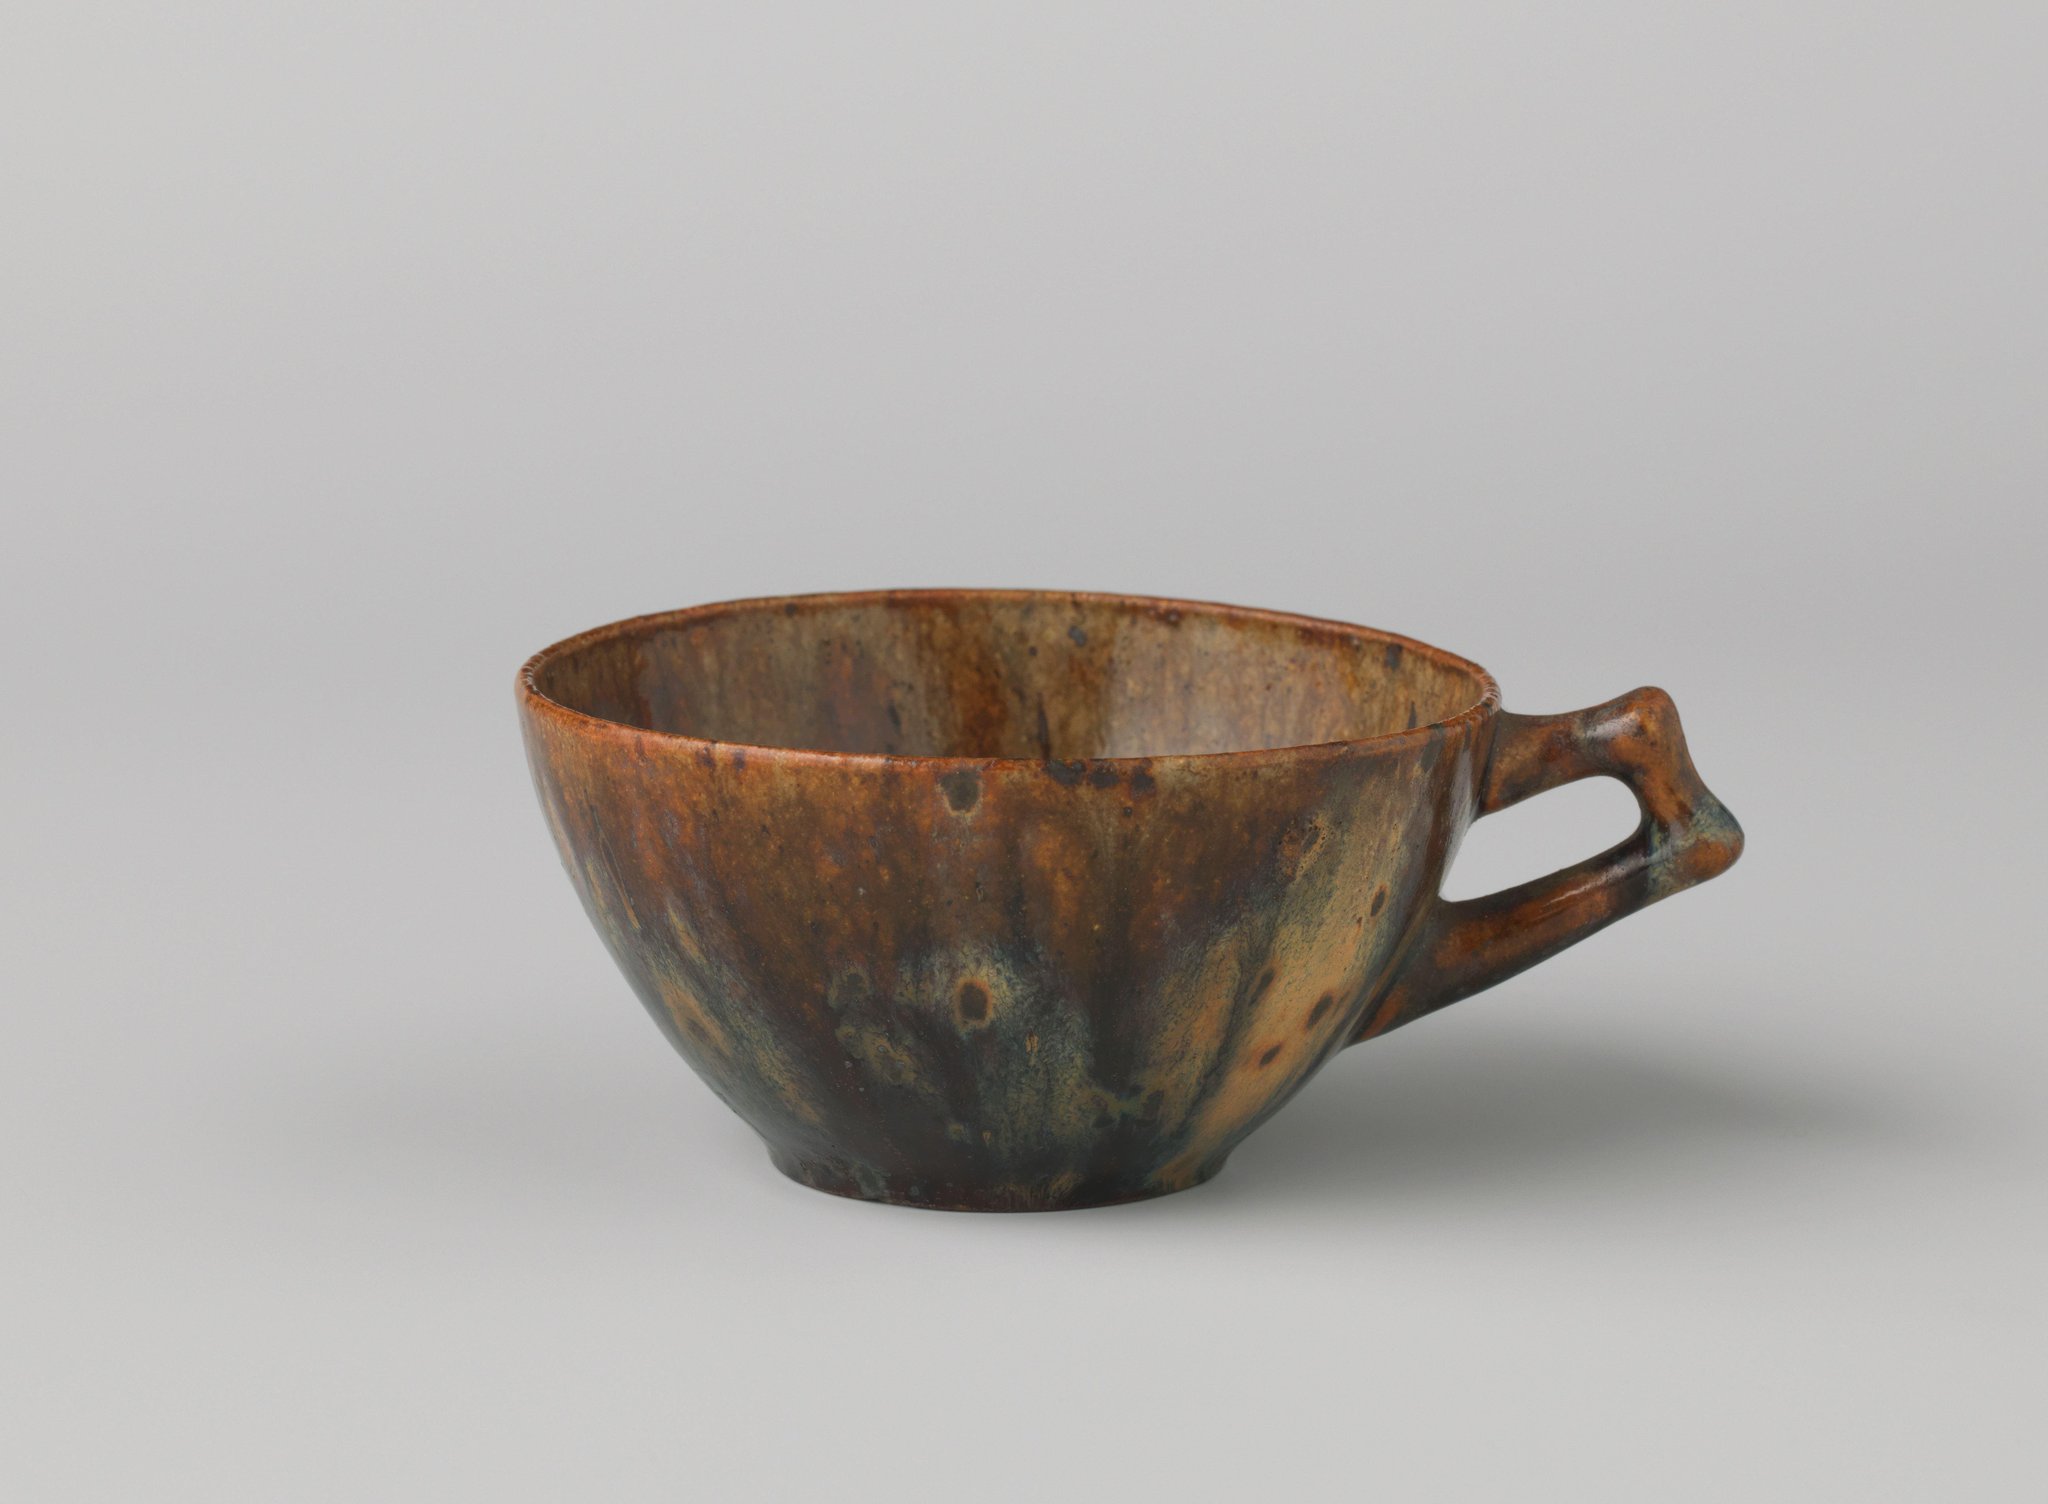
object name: cup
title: Set of Two Cups and Saucers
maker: pierre adrien dalpayrat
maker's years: 1844-1910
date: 1900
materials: earthenware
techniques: vitrification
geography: bourg-la-reine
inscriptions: mark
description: Kop van aardewerk met een gevlamde roodbruine en gele glazuur.